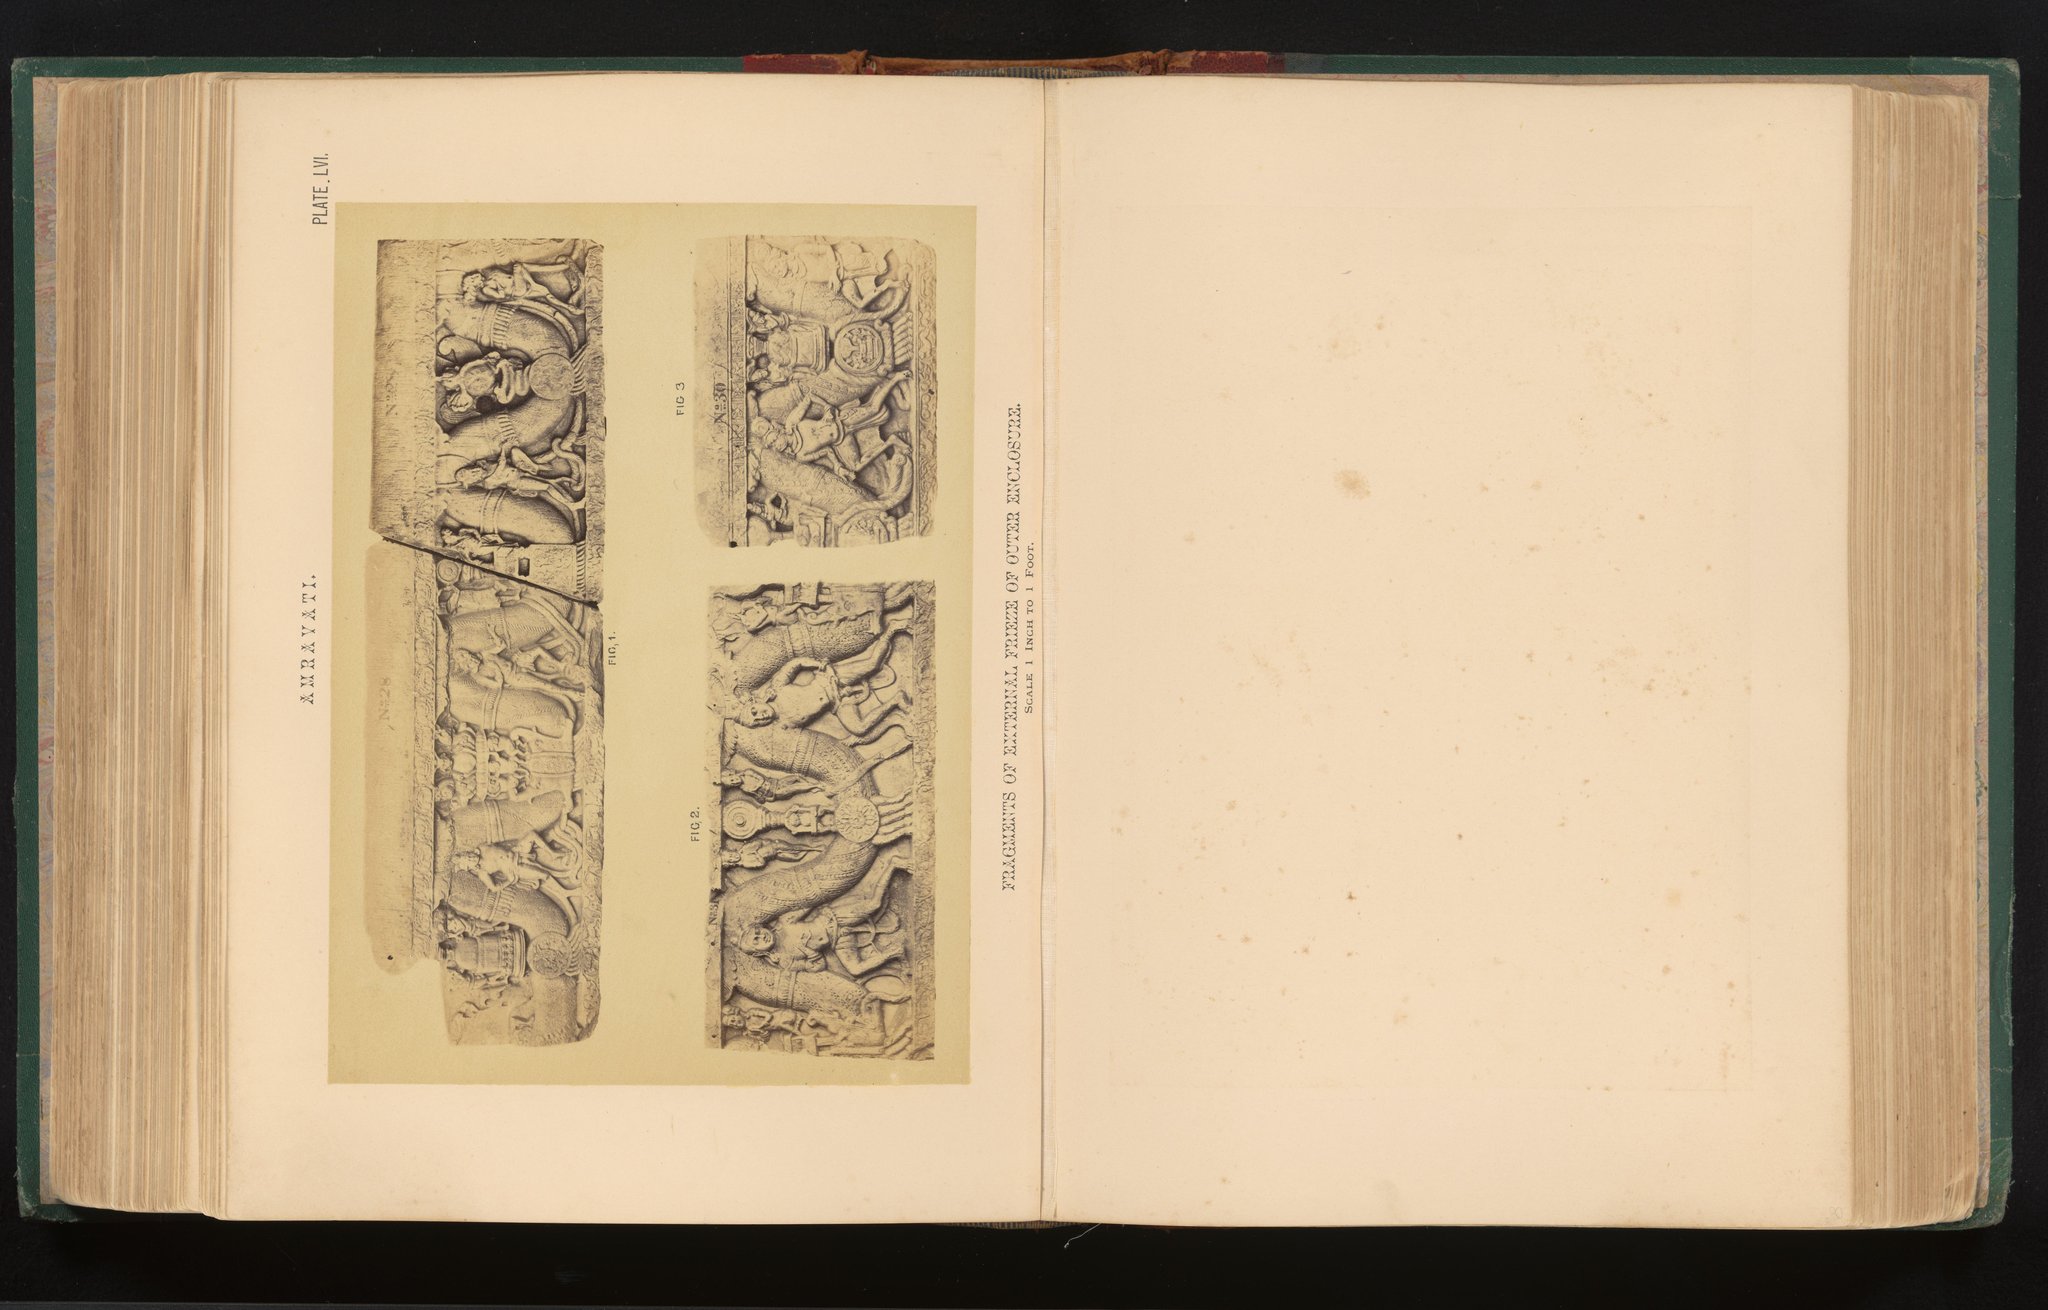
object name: photograph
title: Three fragments of a frieze, Amaravati, Andhra Pradesh, India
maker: william h. griggs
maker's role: printer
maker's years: 1832-1911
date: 1863-1868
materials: photographic support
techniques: albumen print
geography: amaravati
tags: hinduism, buddhism, jainism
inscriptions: inscription: ‘AMRAVATI. PLATE LVI.’, inscription: ‘FRAGMENTS OF EXTERNAL FRIEZE OF OUTER ENCLOSURE./ SCALE 1 INCH TO 1 FOOT.’